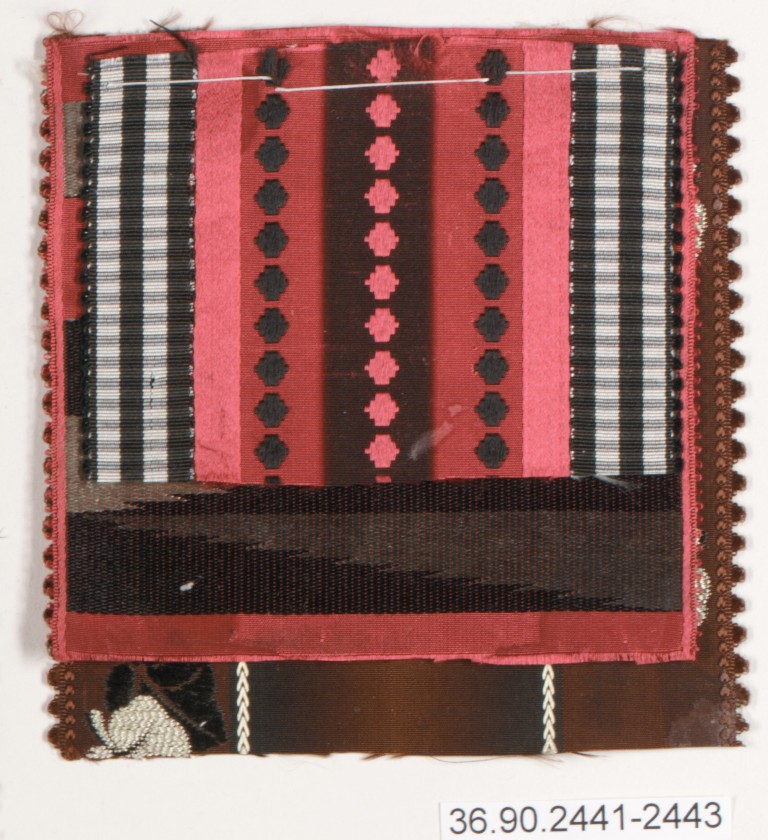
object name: ribbon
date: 1801-1900